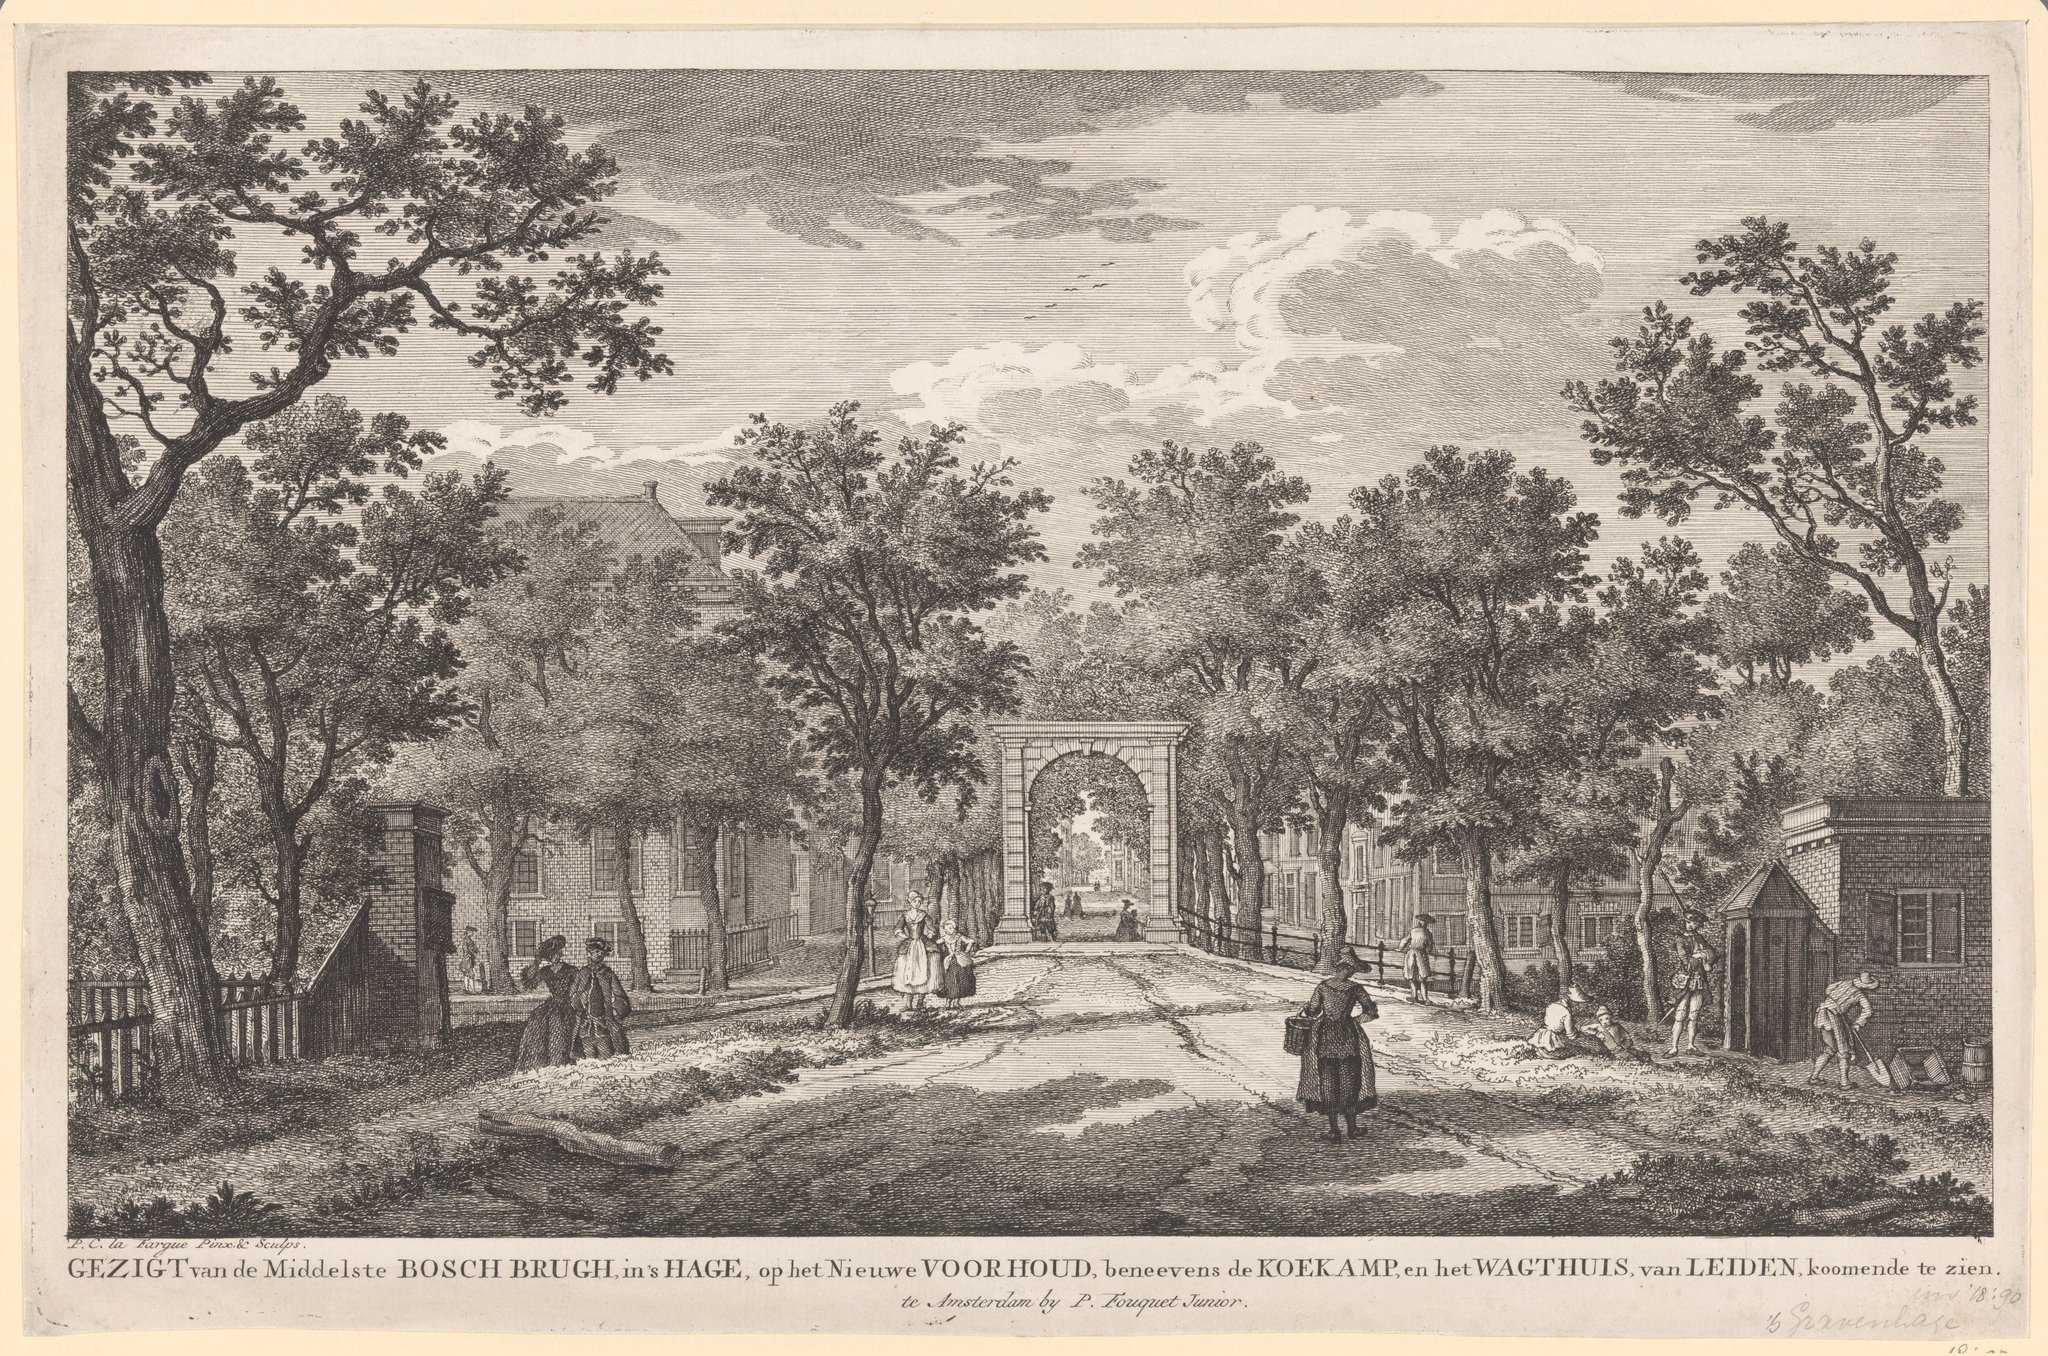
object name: print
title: Acht gezichten in Den Haag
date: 1764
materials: paper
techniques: engraving, etching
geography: the hague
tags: bridge in city across river, canal, etc., guard duty, keeping sentry, lane, alley (+ city(-scape) with figures, staffage)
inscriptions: collector's mark: Lugt 2228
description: Gezicht op de Bosbrug over de Prinsessegracht te Den Haag met daarachter het Korte Voorhout (voorheen Nieuwe Voorhout). Voor de brug de Koekamp met geheel rechts een schildwacht bij een wachtershuis. Prent uit een serie van acht gezichten in Den Haag